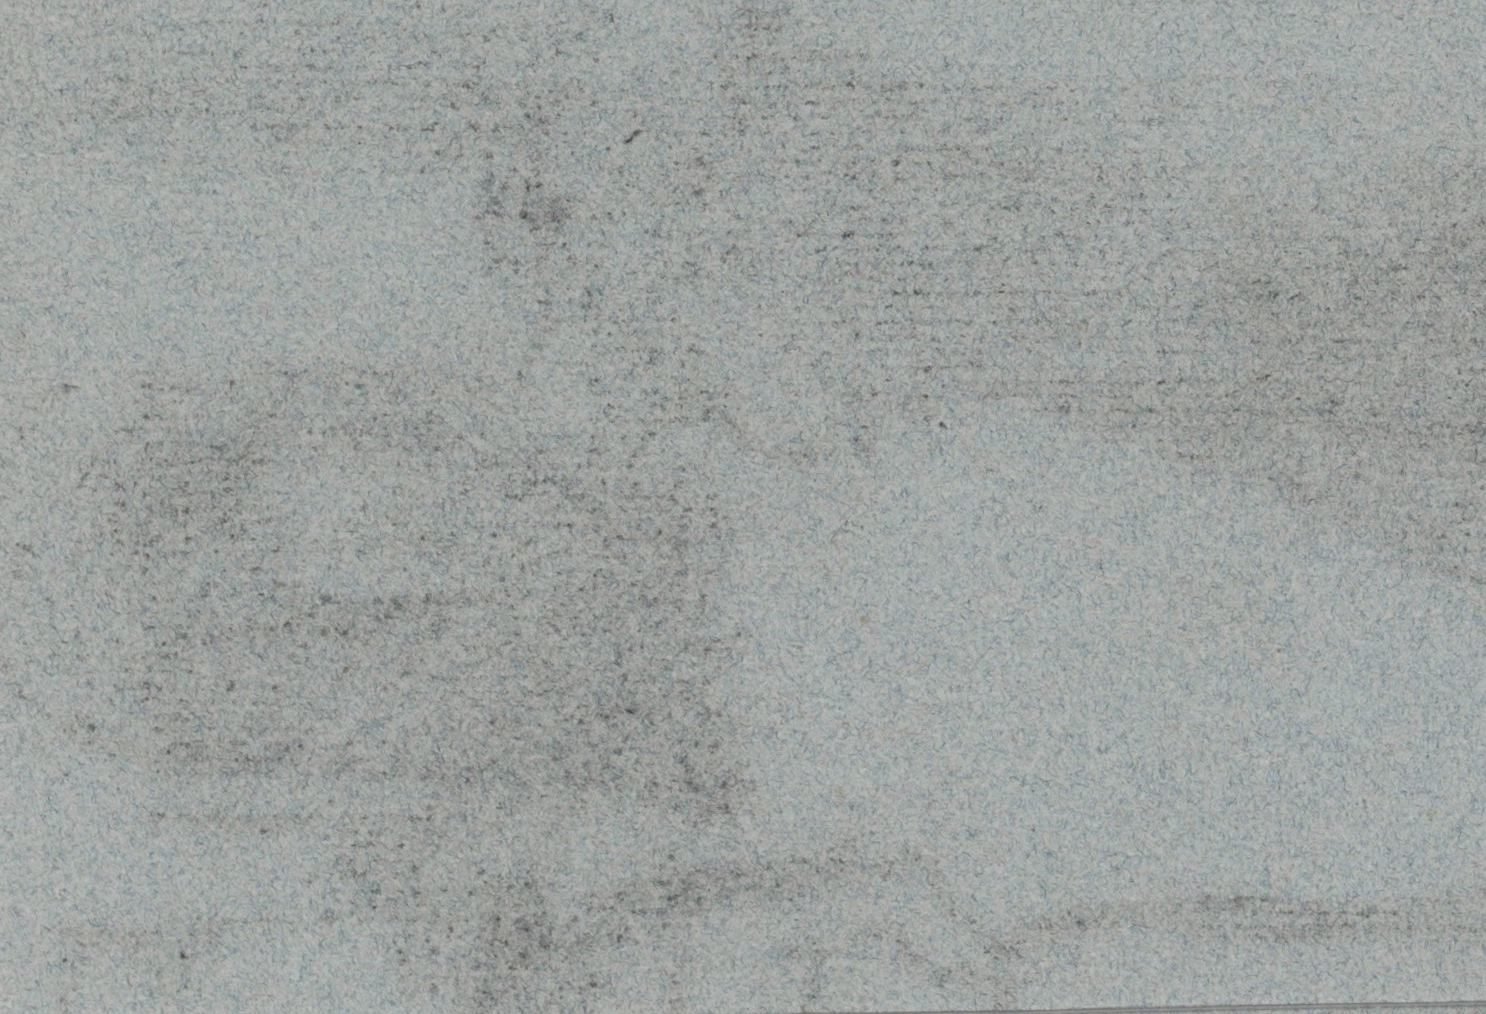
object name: sketchbook leaf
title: Abklatsch van de krijttekening op blad 5 recto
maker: isaac israels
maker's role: draughtsman, painter, print maker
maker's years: 1865-1934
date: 1875-1934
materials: paper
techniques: printmaking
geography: the hague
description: Blad 4 verso uit schetsboek XXX met 32 bladen.